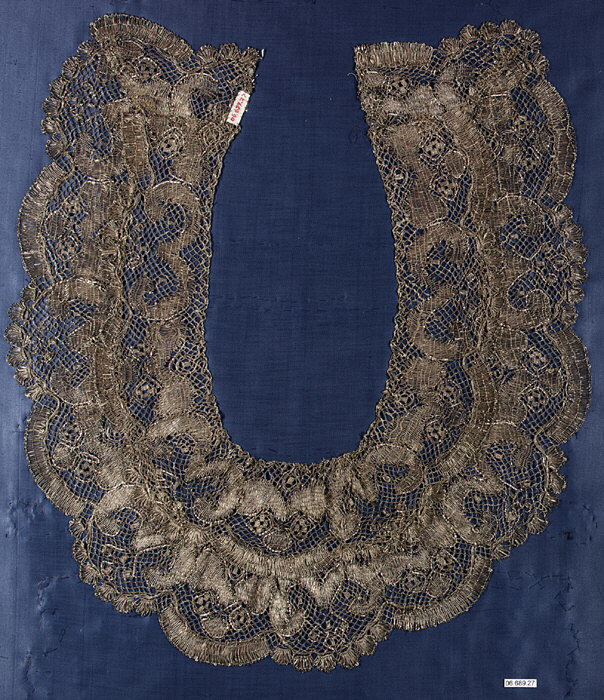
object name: collar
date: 1701-1800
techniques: lace